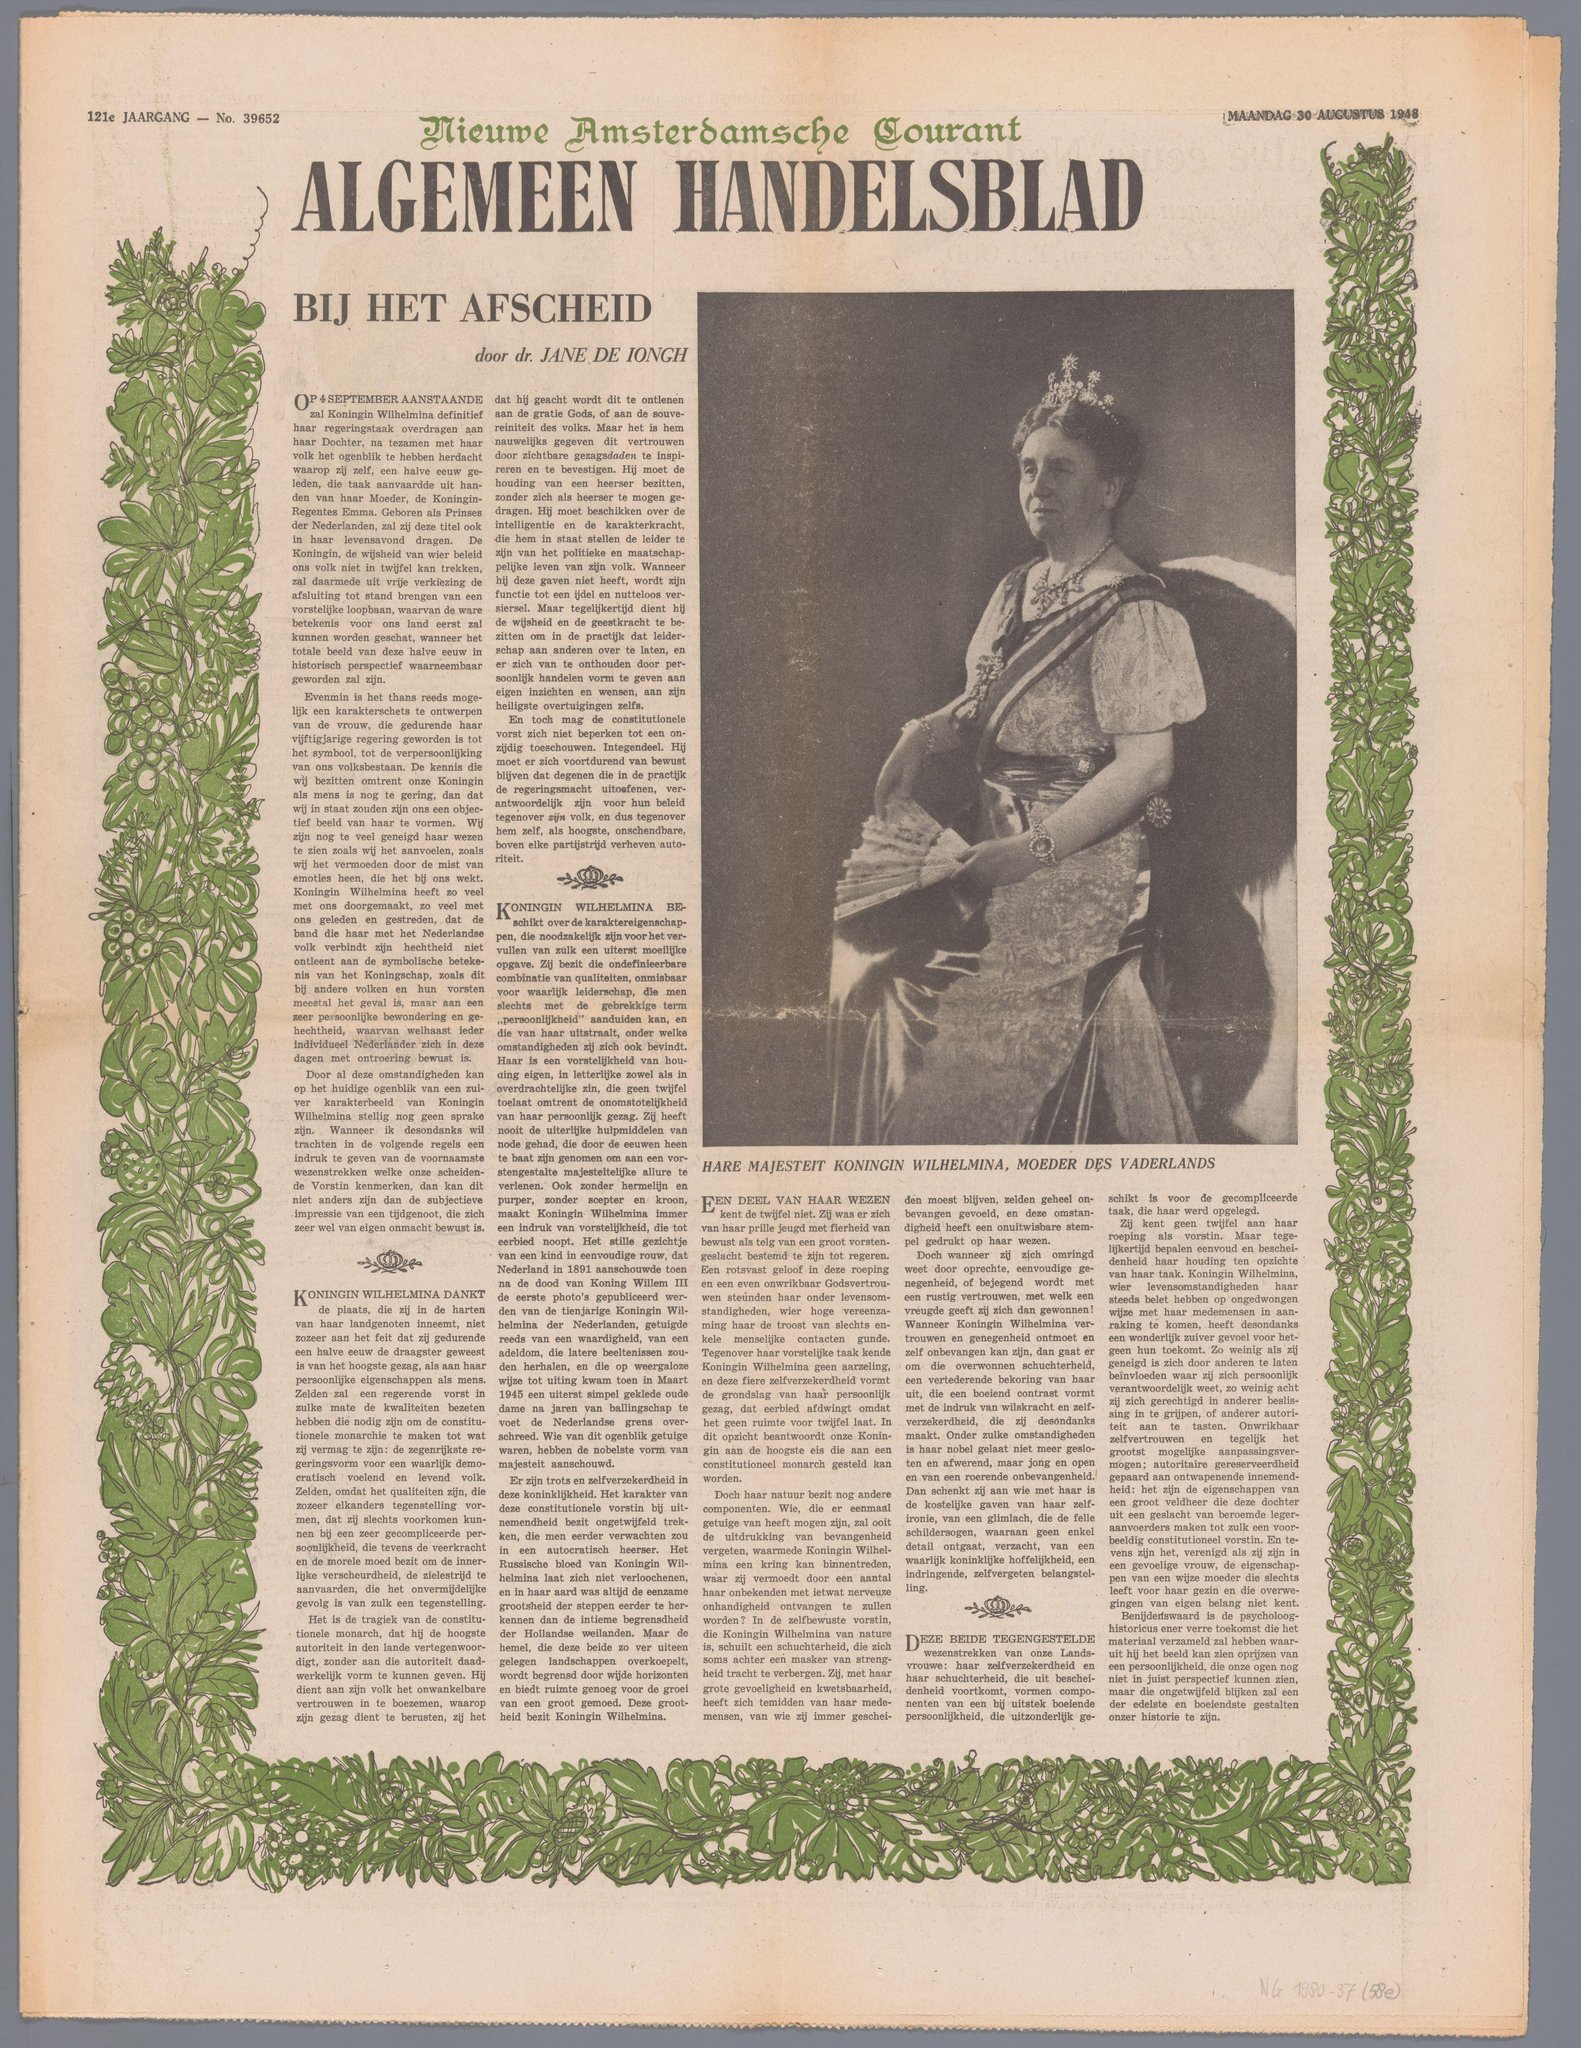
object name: newspaper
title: Algemeen Handelsblad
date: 1948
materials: paper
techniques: printing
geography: amsterdam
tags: the hague, print maker, wilhelmina of the netherlands, juliana of the netherlands, netherlands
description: Krant over de inhuldiging van Juliana, nr. 39652 van de 121ste jaargang van de Algemeen Handelsblad, 6 pp.